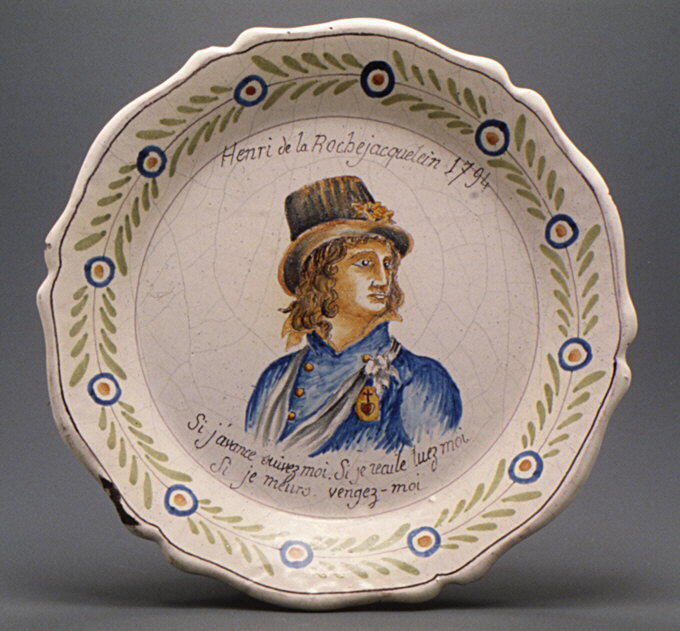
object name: plate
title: Plate with portrait of Henri de Verger, Comte de la Rochejaquelein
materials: faience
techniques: glazing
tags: portraits